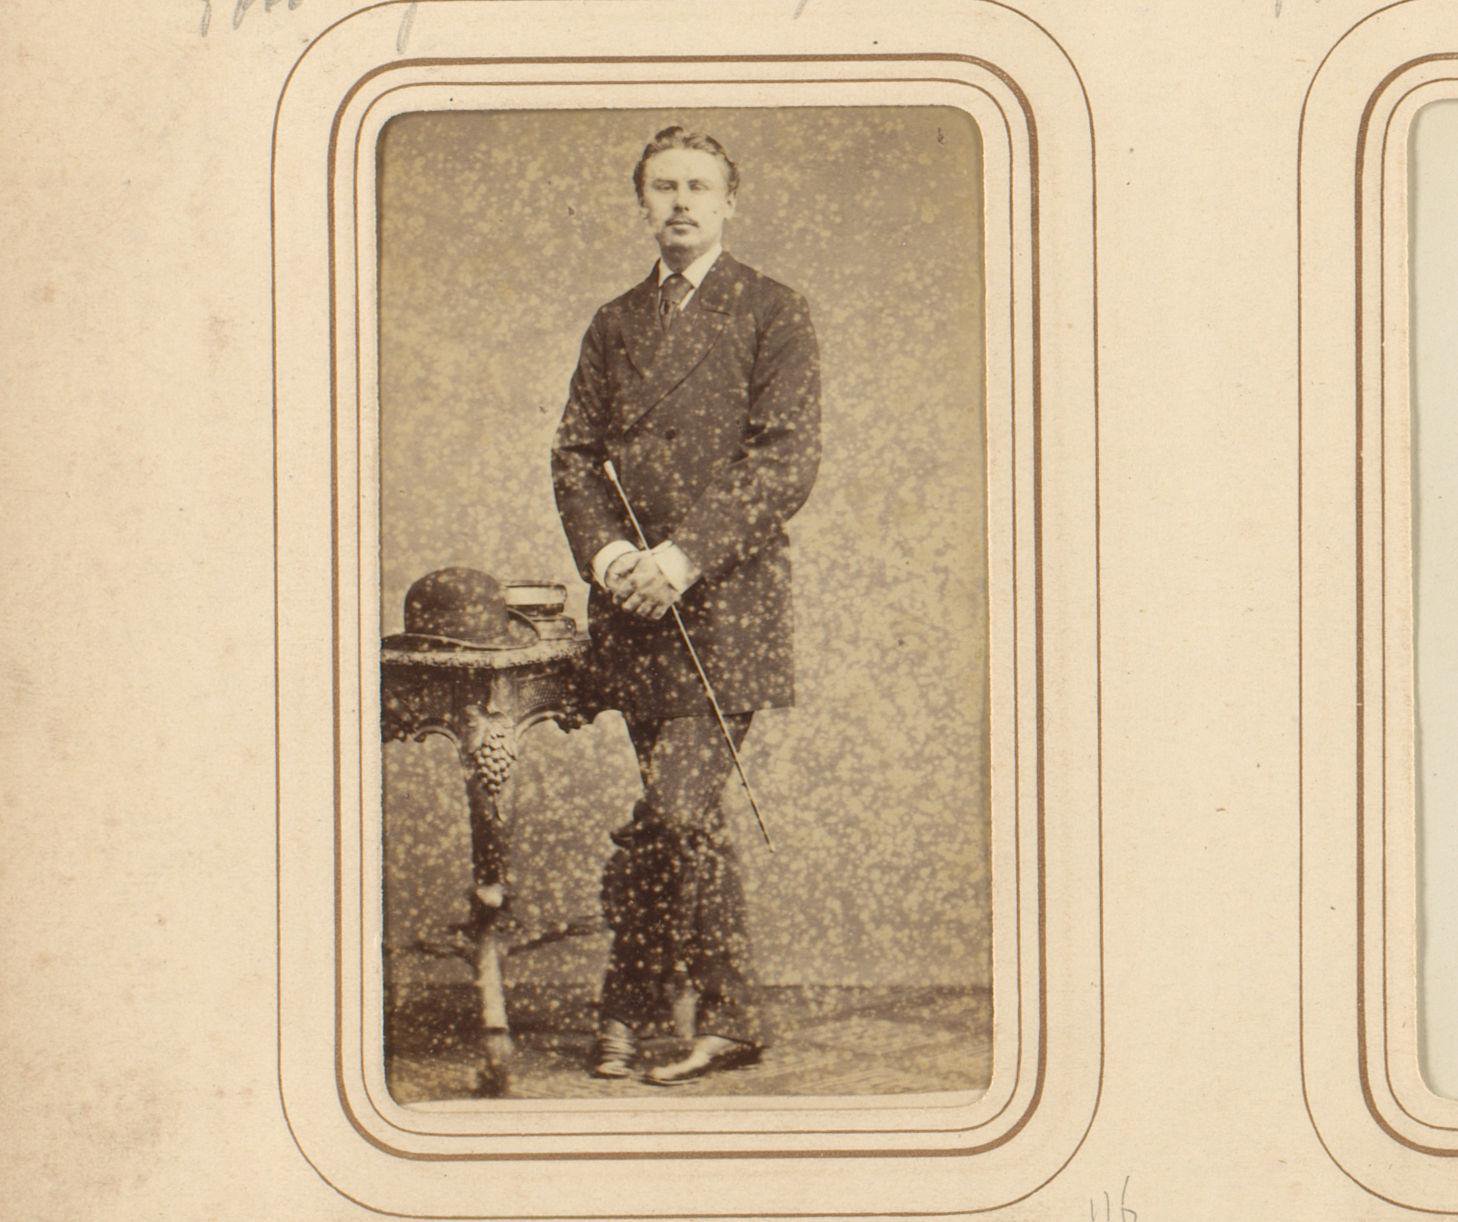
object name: photograph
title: Portret van een man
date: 1865-1890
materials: cardboard, photographic support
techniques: albumen print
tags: adult man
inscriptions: inscription: ‘Wegner & Mottu Amsterdam-Utrecht’, inscription: ‘Photogr Atellier/ van/ Wegner & Mottu/ Kalverstraat D 36/ Amsterdam/ Leijdschestraatweg buiten Cathrijnen/ (...)’